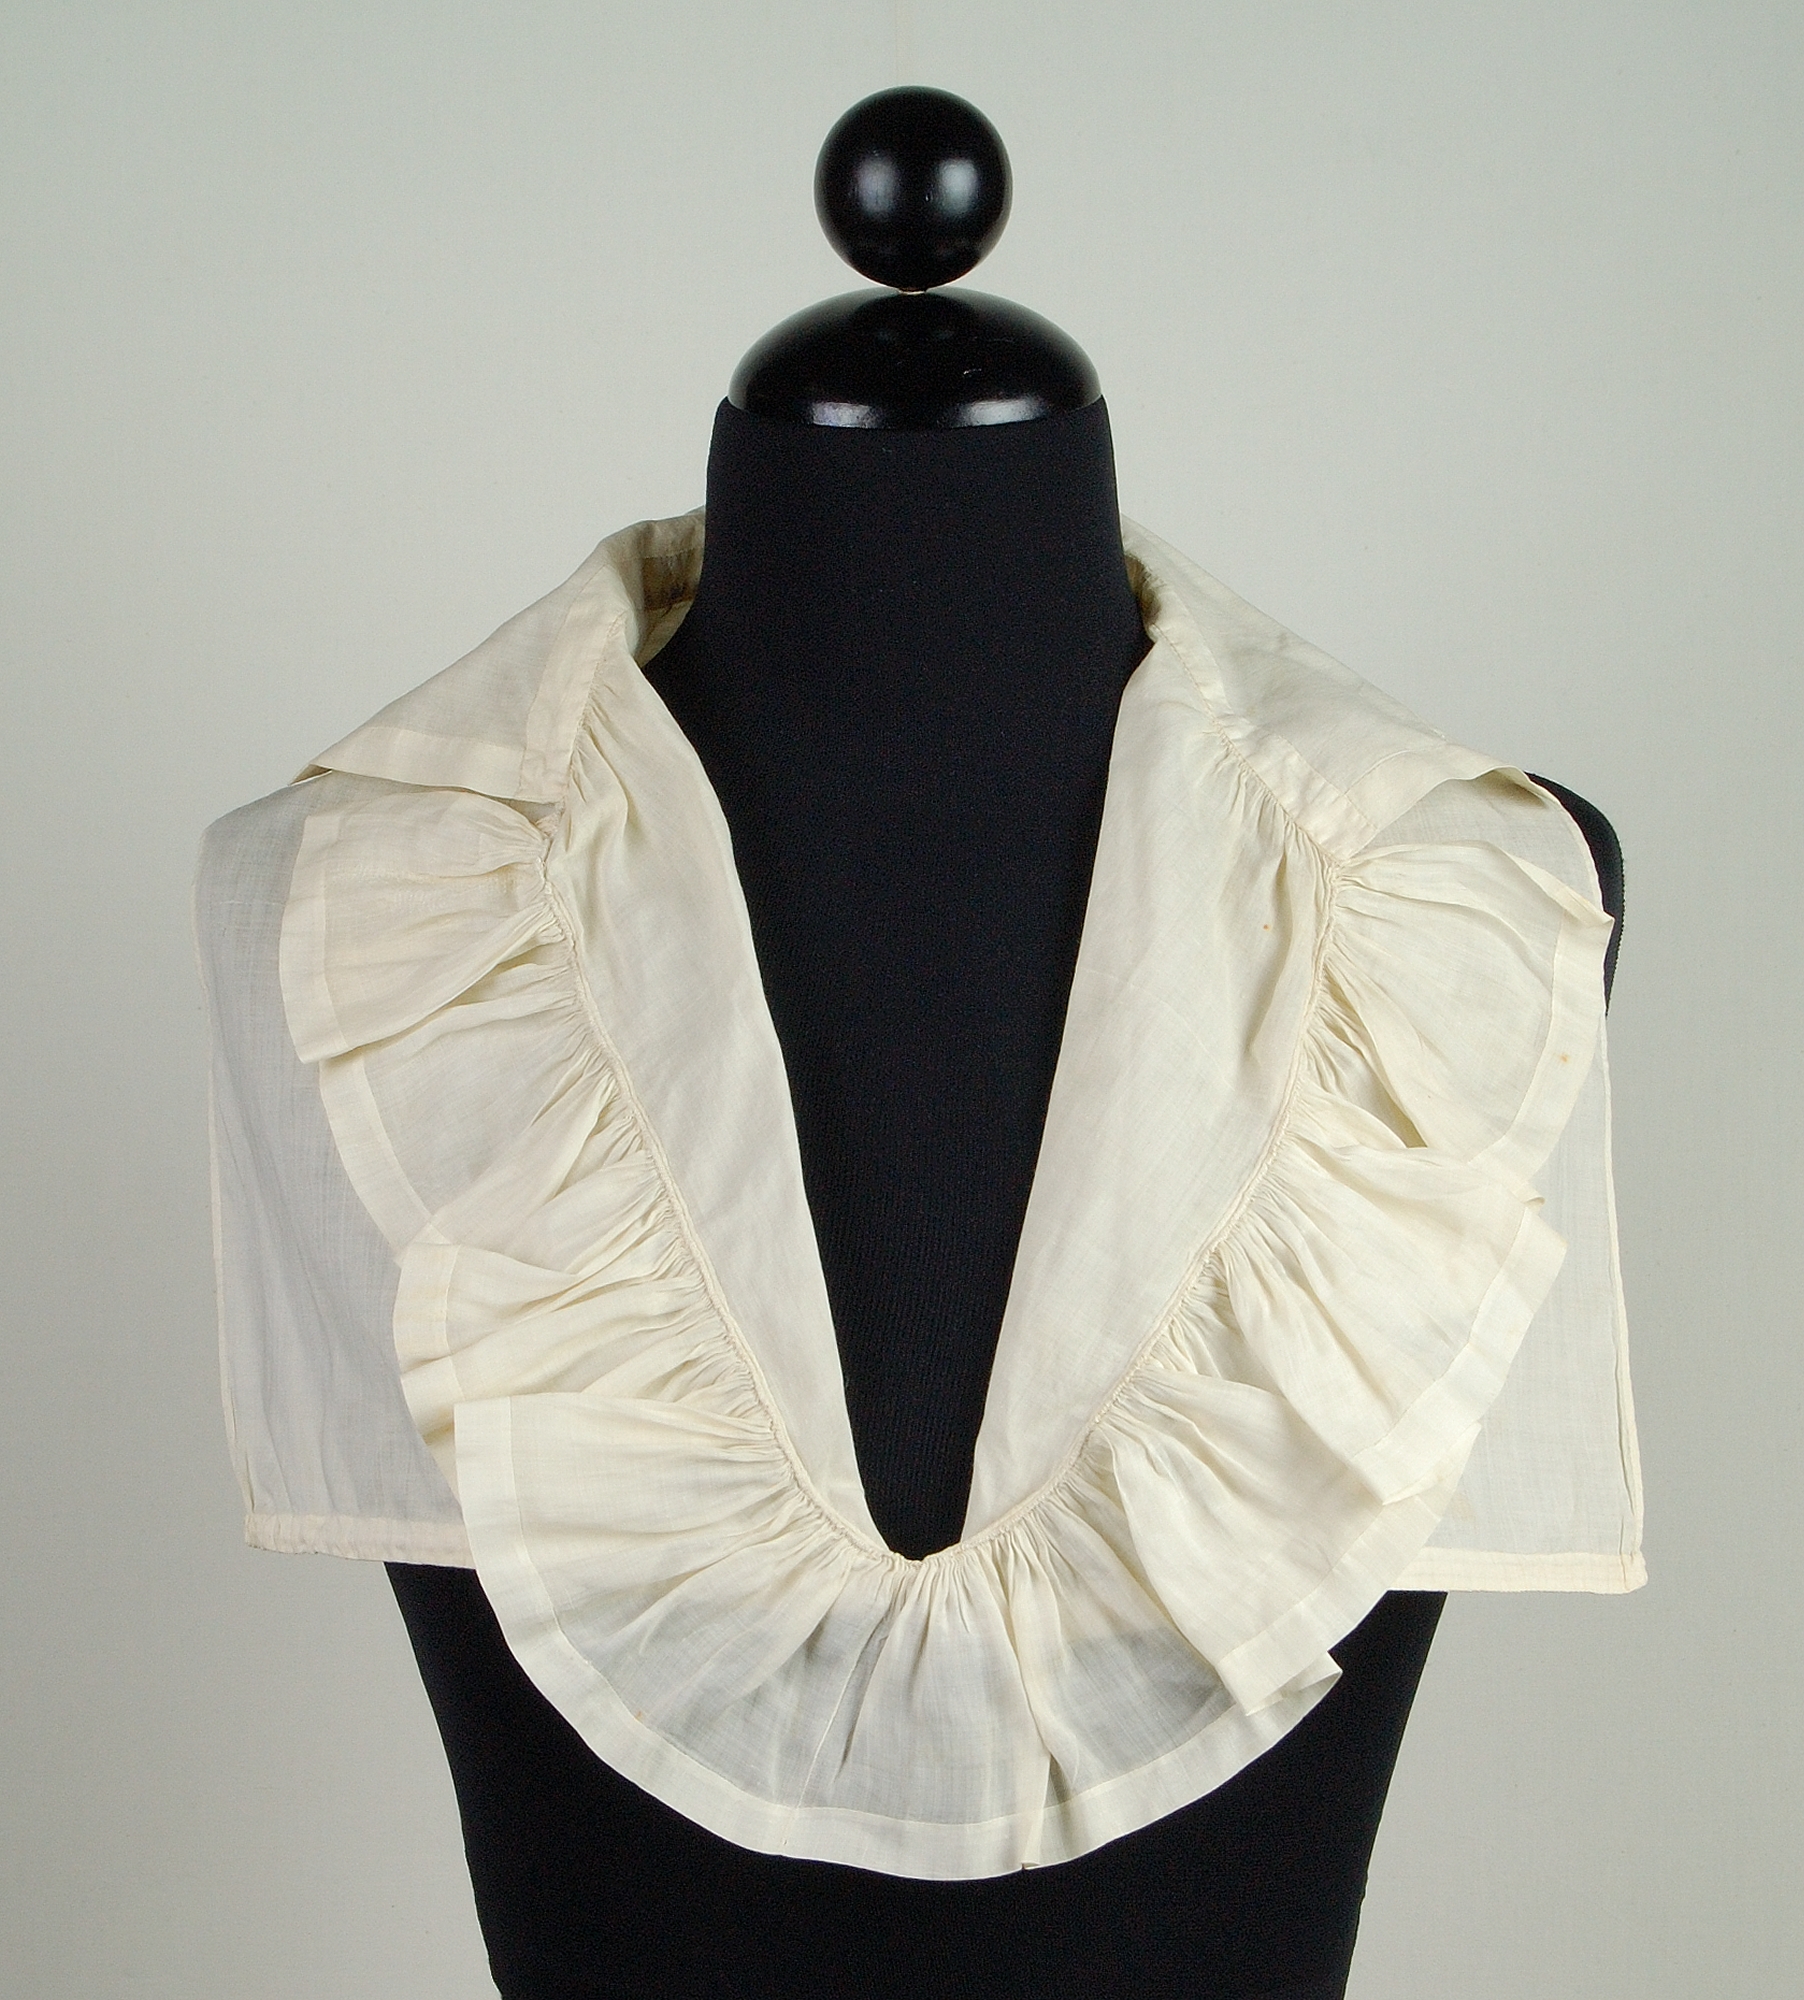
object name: chemise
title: Chemisette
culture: american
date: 1855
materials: linen